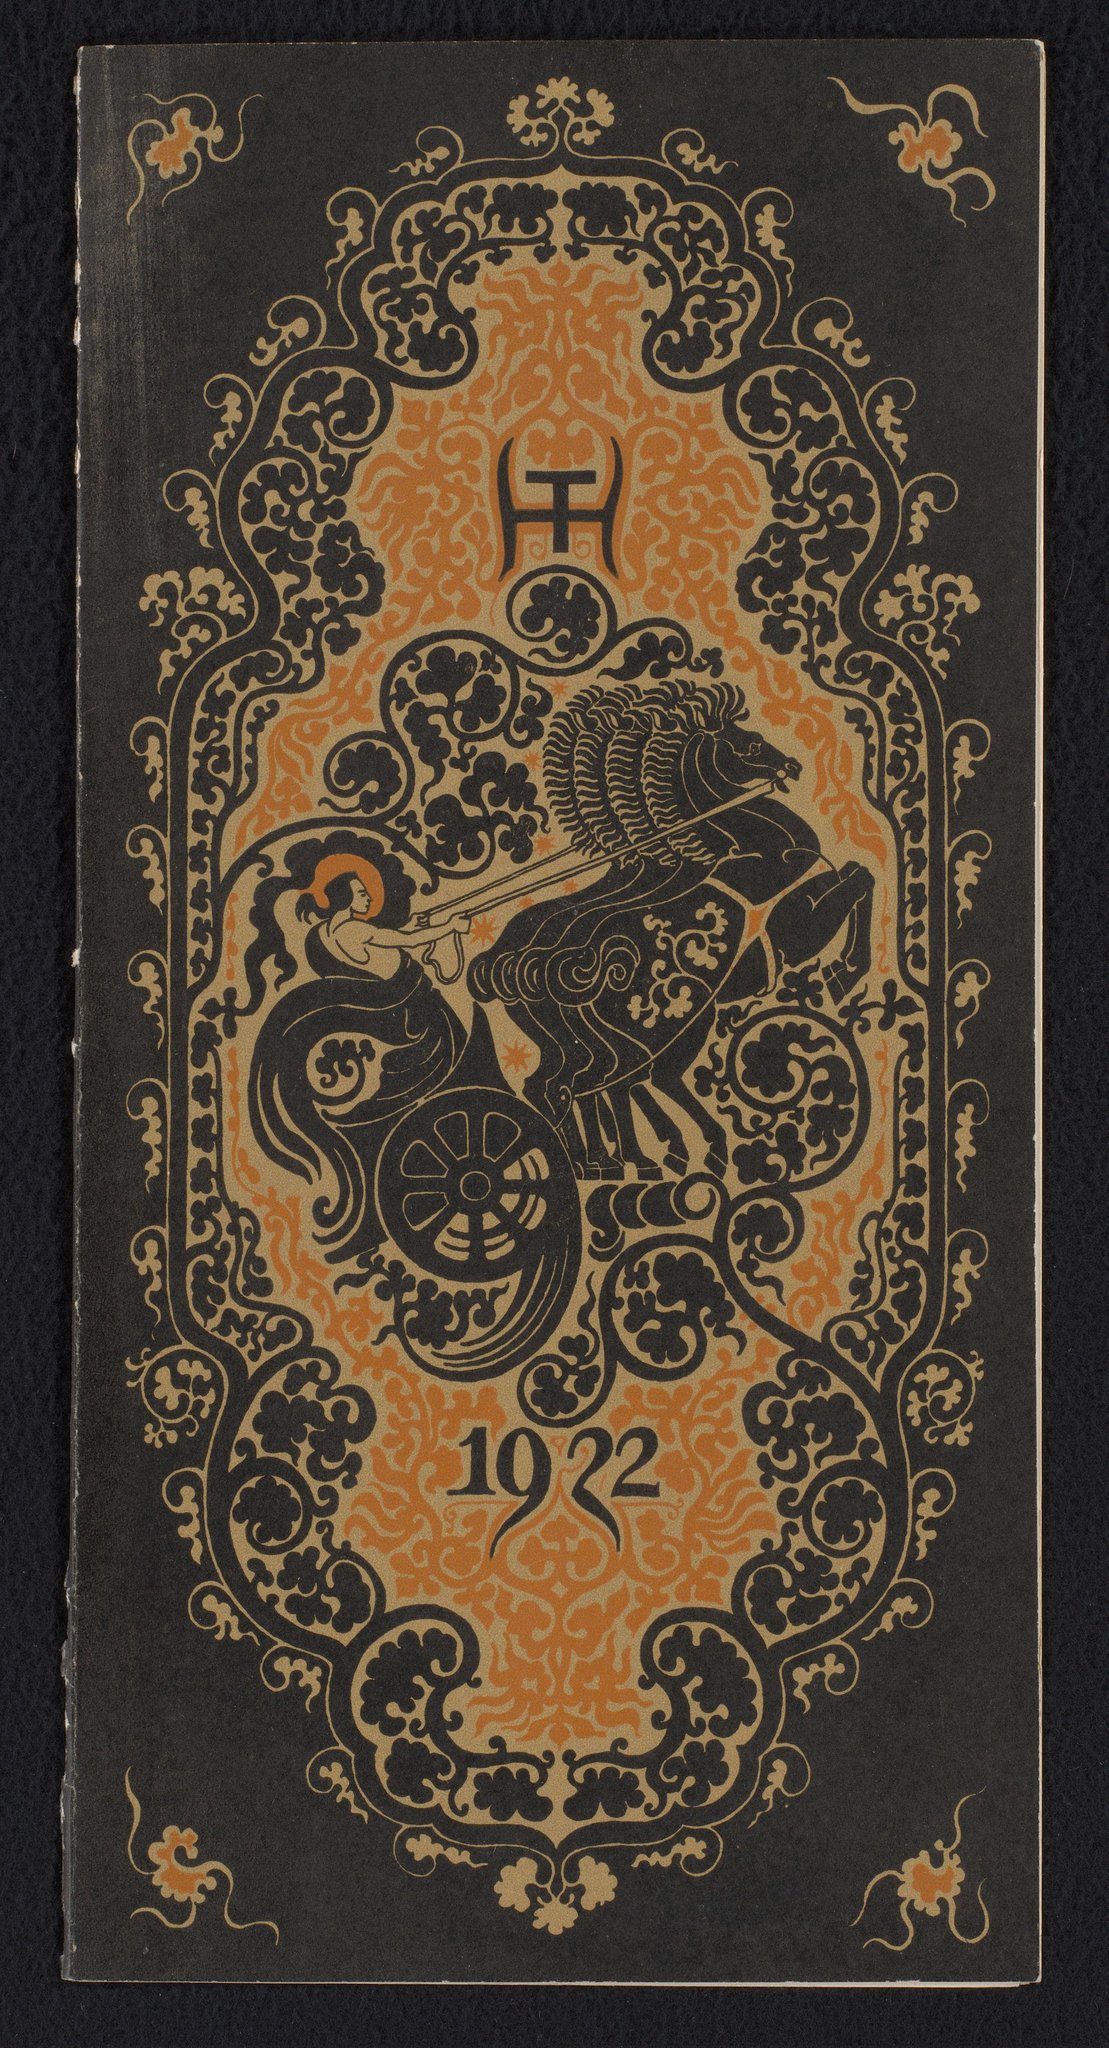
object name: photomechanical print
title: Omslag voor een kalender van 1922 van Drukkerij Ten Hagen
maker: Anonymous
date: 1921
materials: cardboard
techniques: letterpress printing, printing block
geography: the hague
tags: calendar, almanac, chariot, triumphal car, the hague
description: Op de voorzijde van het omslag een strijdwagen, getrokken door vier steigerende paarden, in een kader van takken en bladeren. Bovenaan het monogram van de drukkerij, onder de strijdwagen het jaartal '1922'. Binnenin een kalender voor het jaar met in het midden een kader met feestdagen en koninklijke verjaardagen.